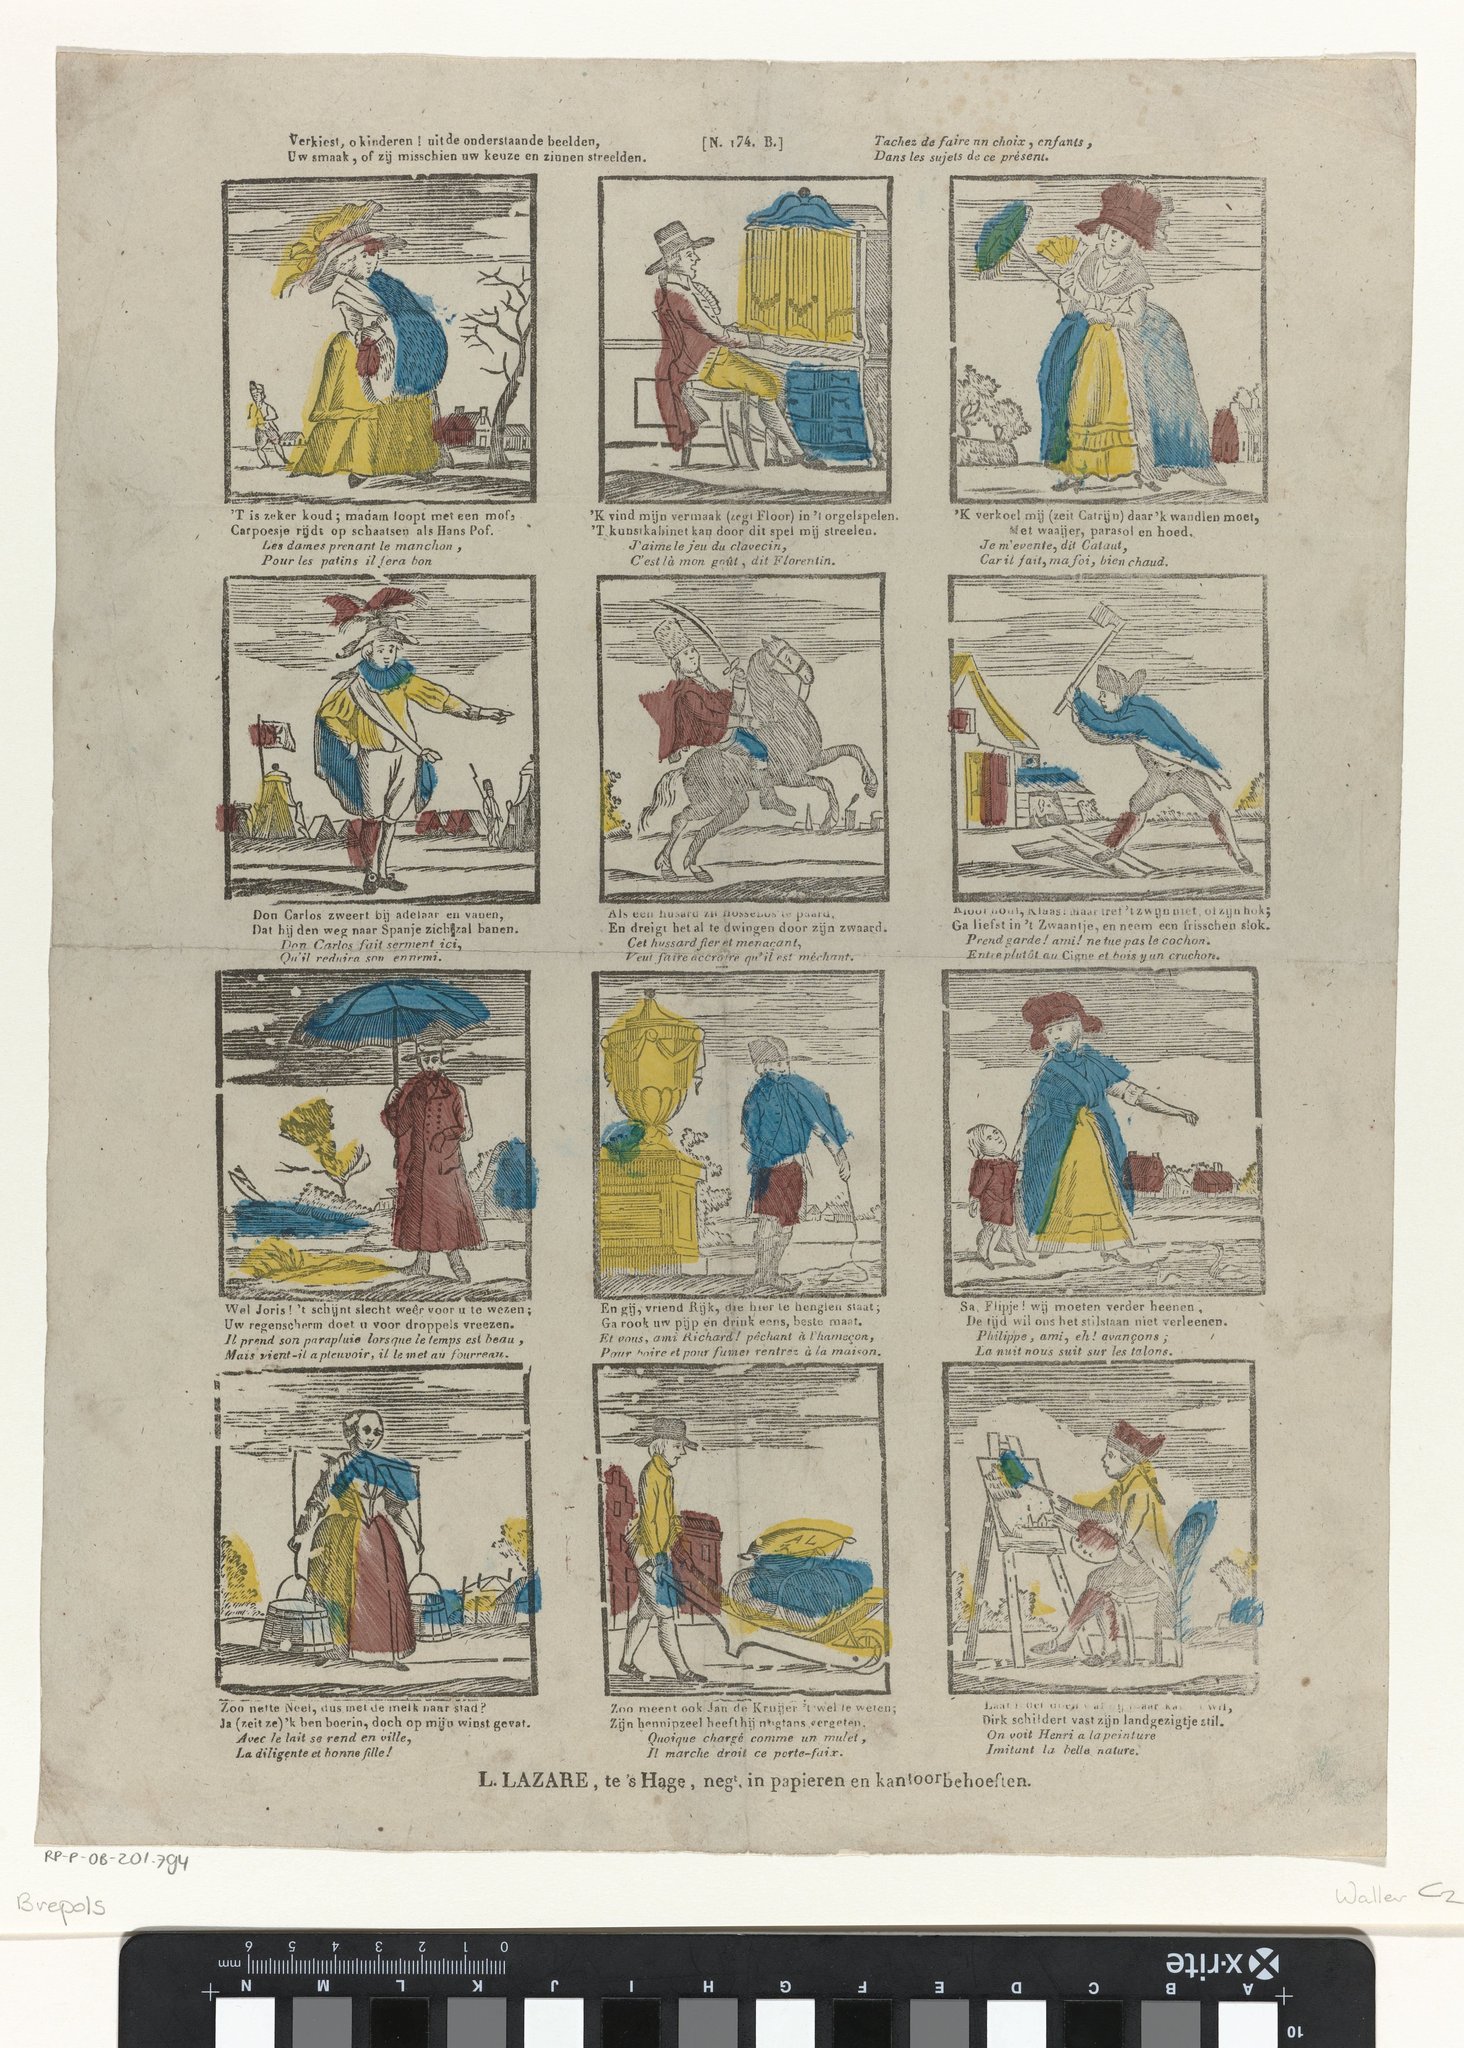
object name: popular print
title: Verkiest, o kinderen! uit de onderstaande beelden, / Uw smaak, of zij misschien uw keuze en zinnen streelden / Tachez de faire un choix, enfants, / Dans les sujets de ce présent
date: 1800-1833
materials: paper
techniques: colour, letterpress printing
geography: the hague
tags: characters (human types)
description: Blad met 12 voorstellingen van verschillende figuren en bezigheden. Onder elke afbeelding een tweeregelig vers in het Nederlands en in het Frans. Genummerd rechtsboven: (N. 174. B.).